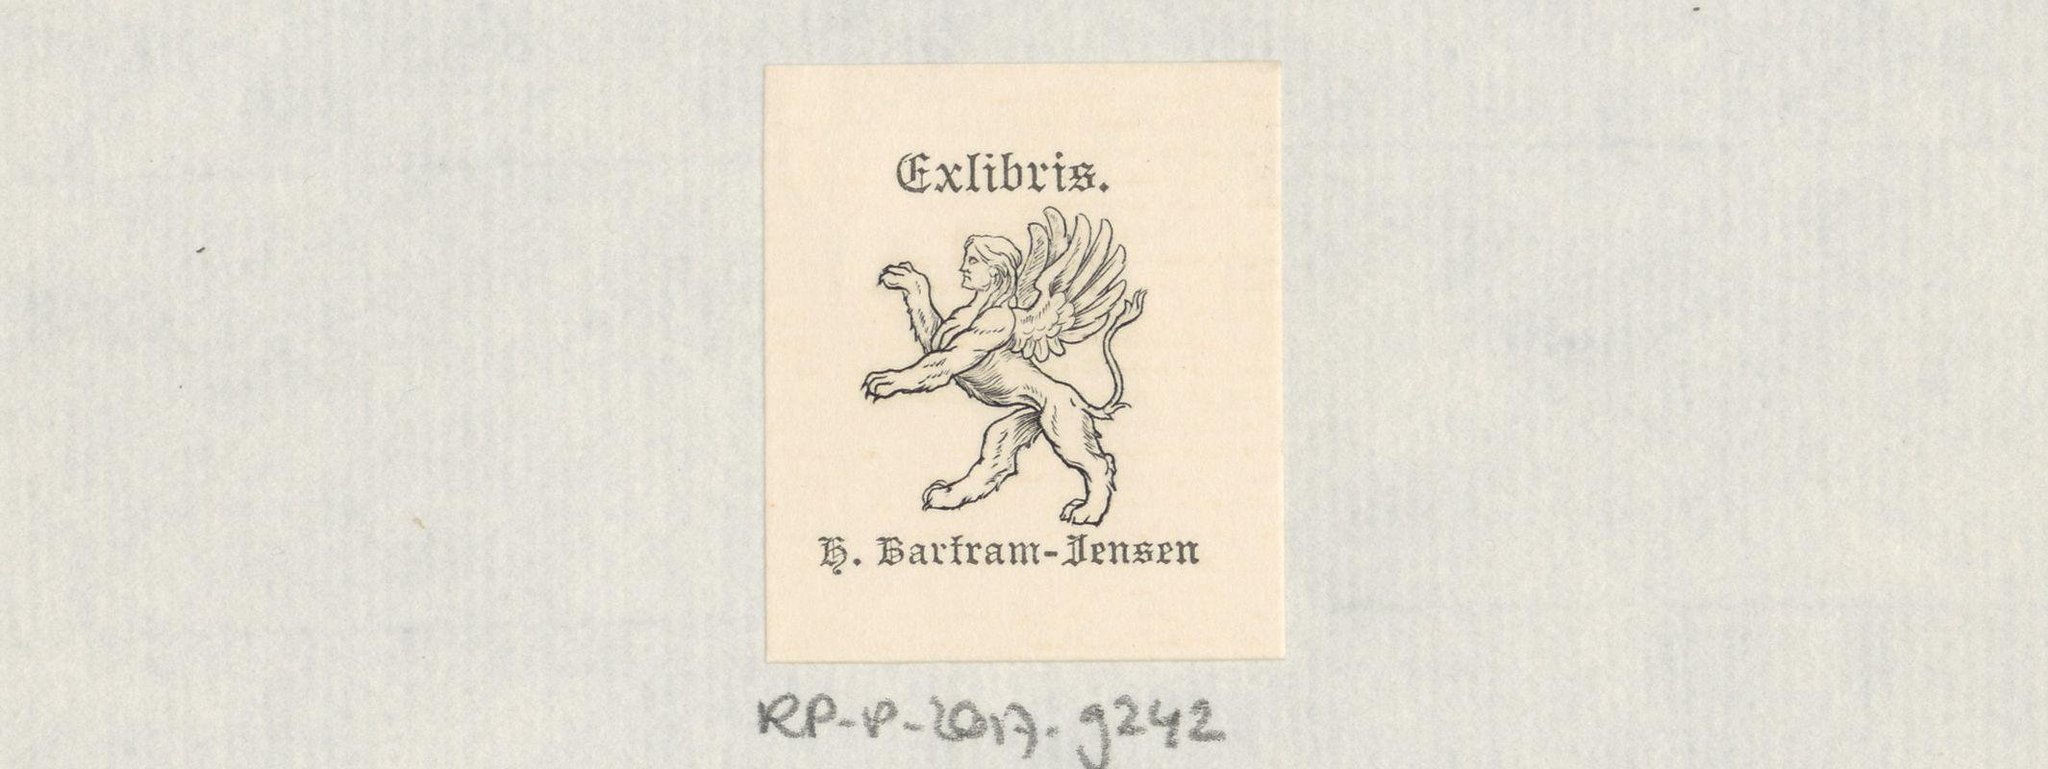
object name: bookplate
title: Exlibris H. Bartram-Jensen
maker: Anonymous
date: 1880-1949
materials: paper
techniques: etching, printing block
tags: griffin (lion/eagle); 'griffo' (ripa), sphinx (lion/woman); 'sfinge' (ripa)